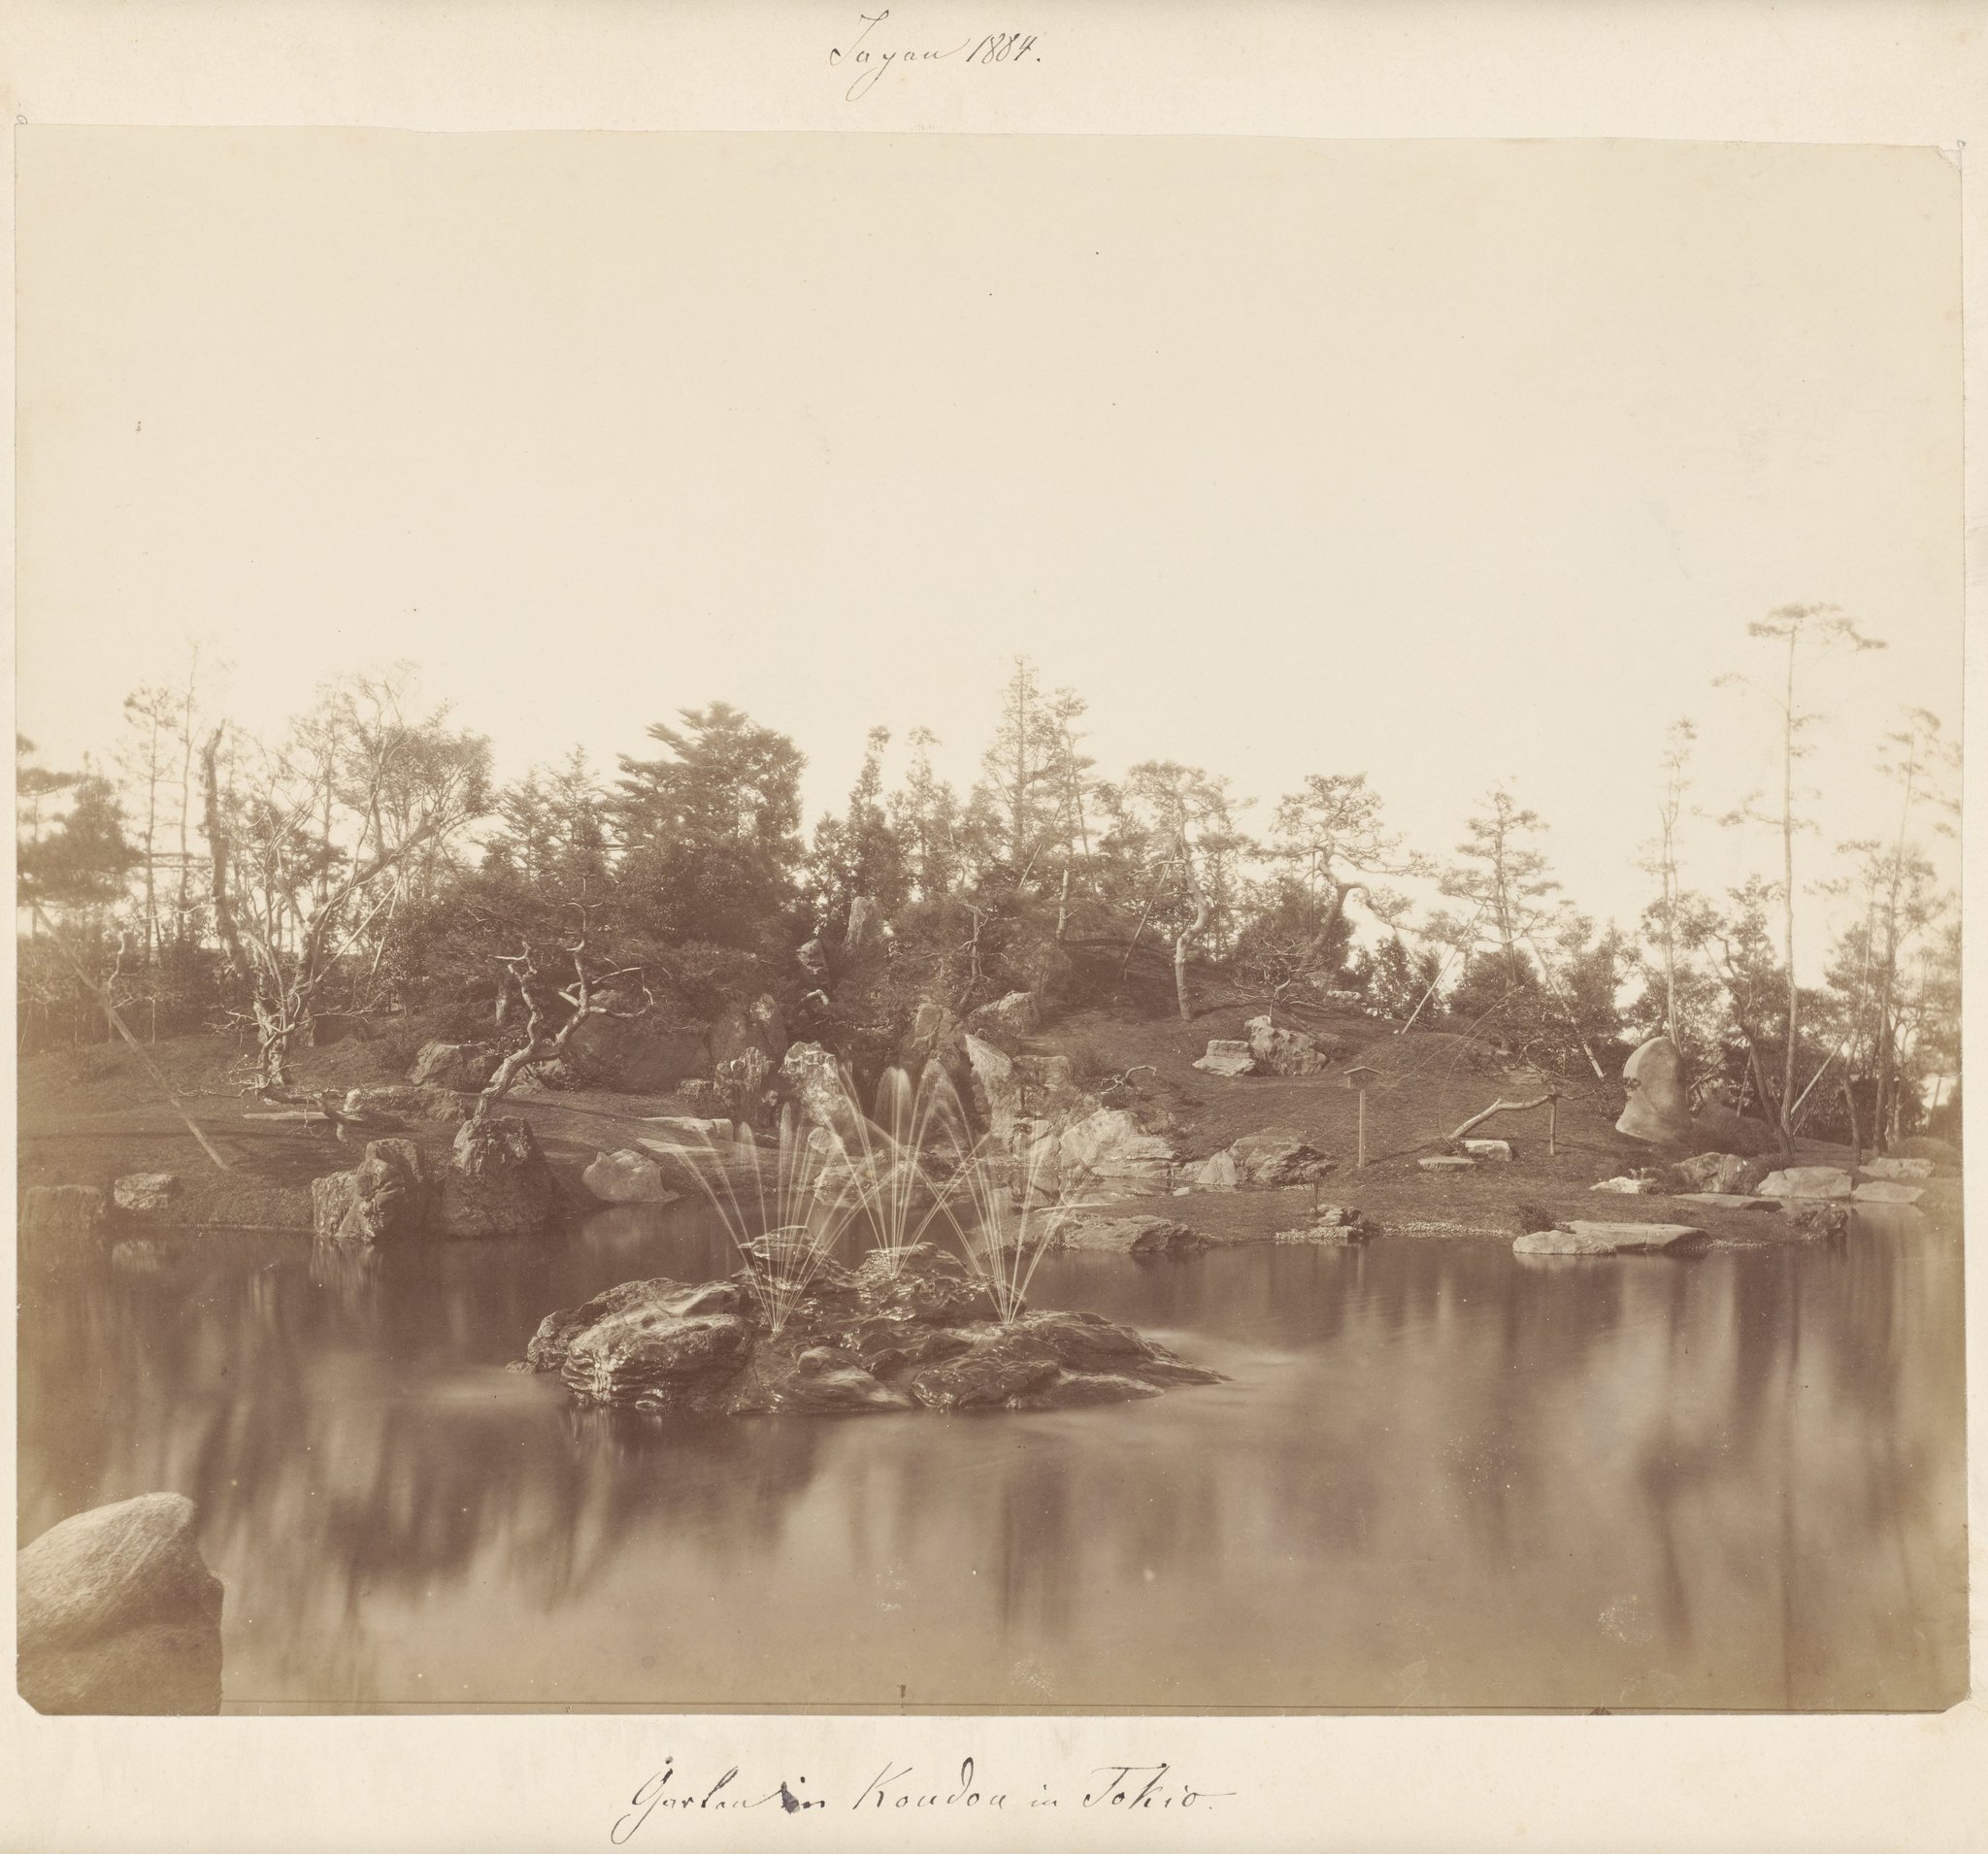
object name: photograph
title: Japan 1884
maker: Anonymous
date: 1884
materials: cardboard, paper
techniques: albumen print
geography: tokyo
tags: garden fountain